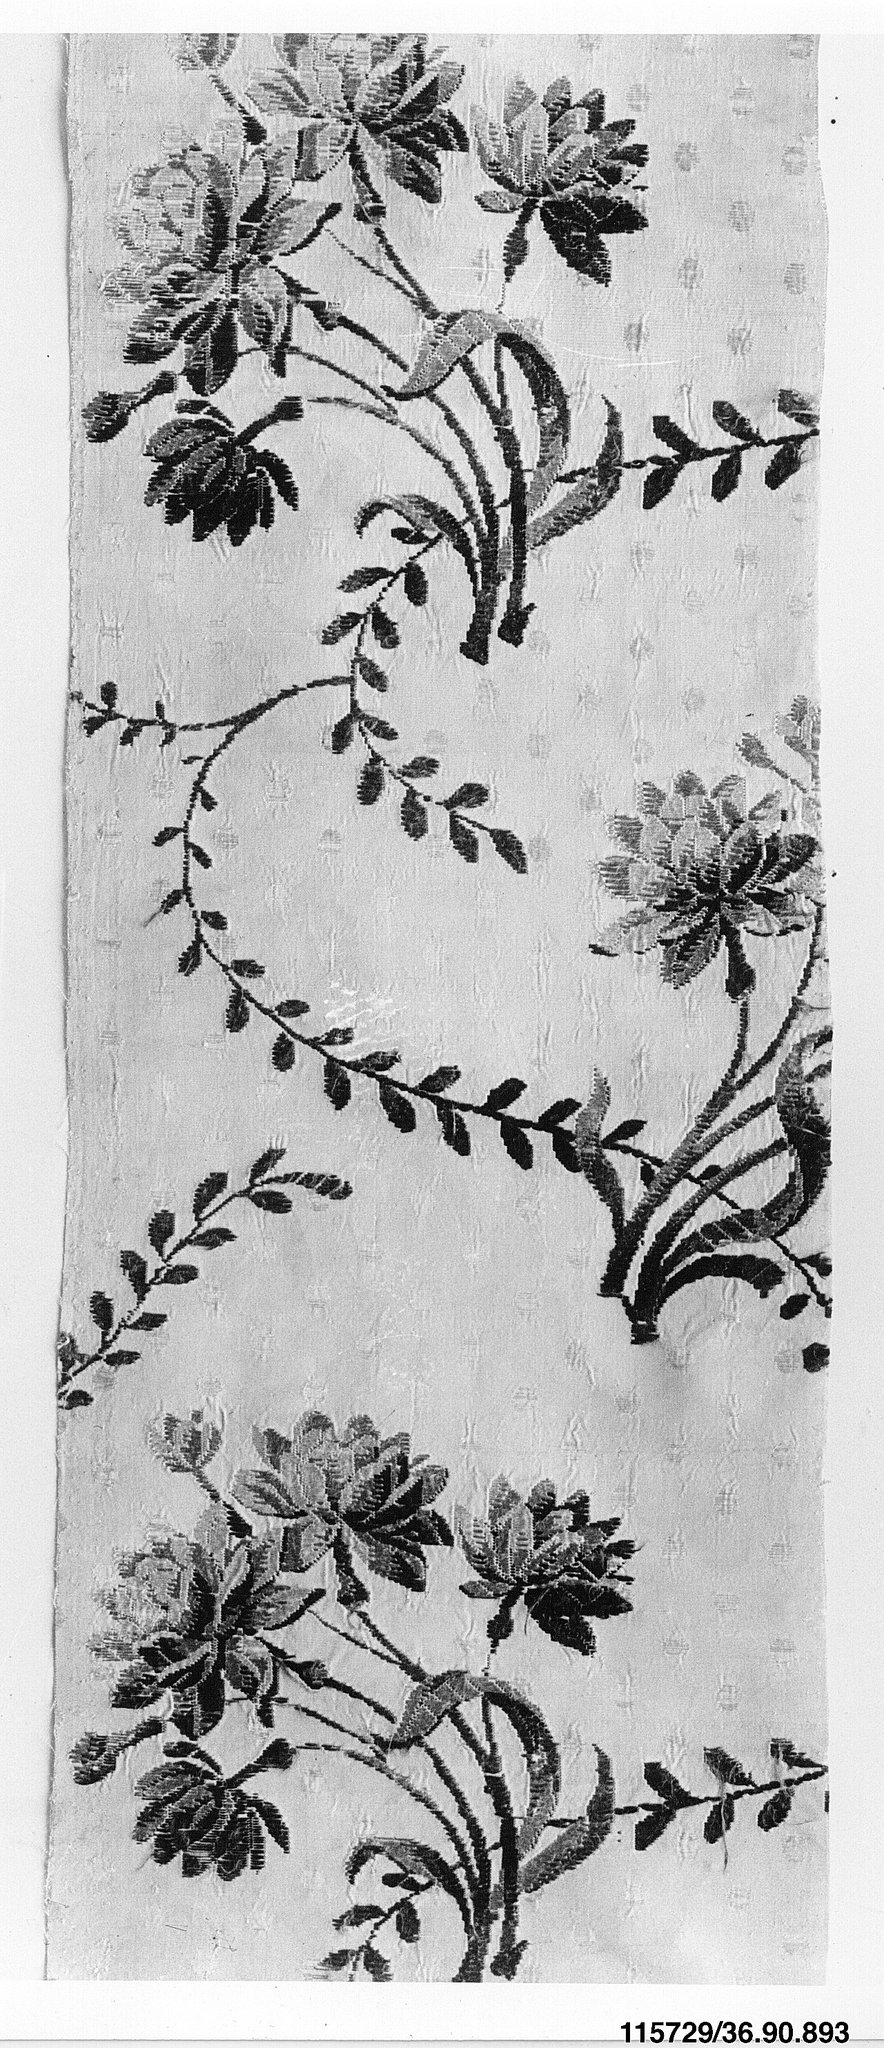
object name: piece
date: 1750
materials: silk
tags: flowers,leaves